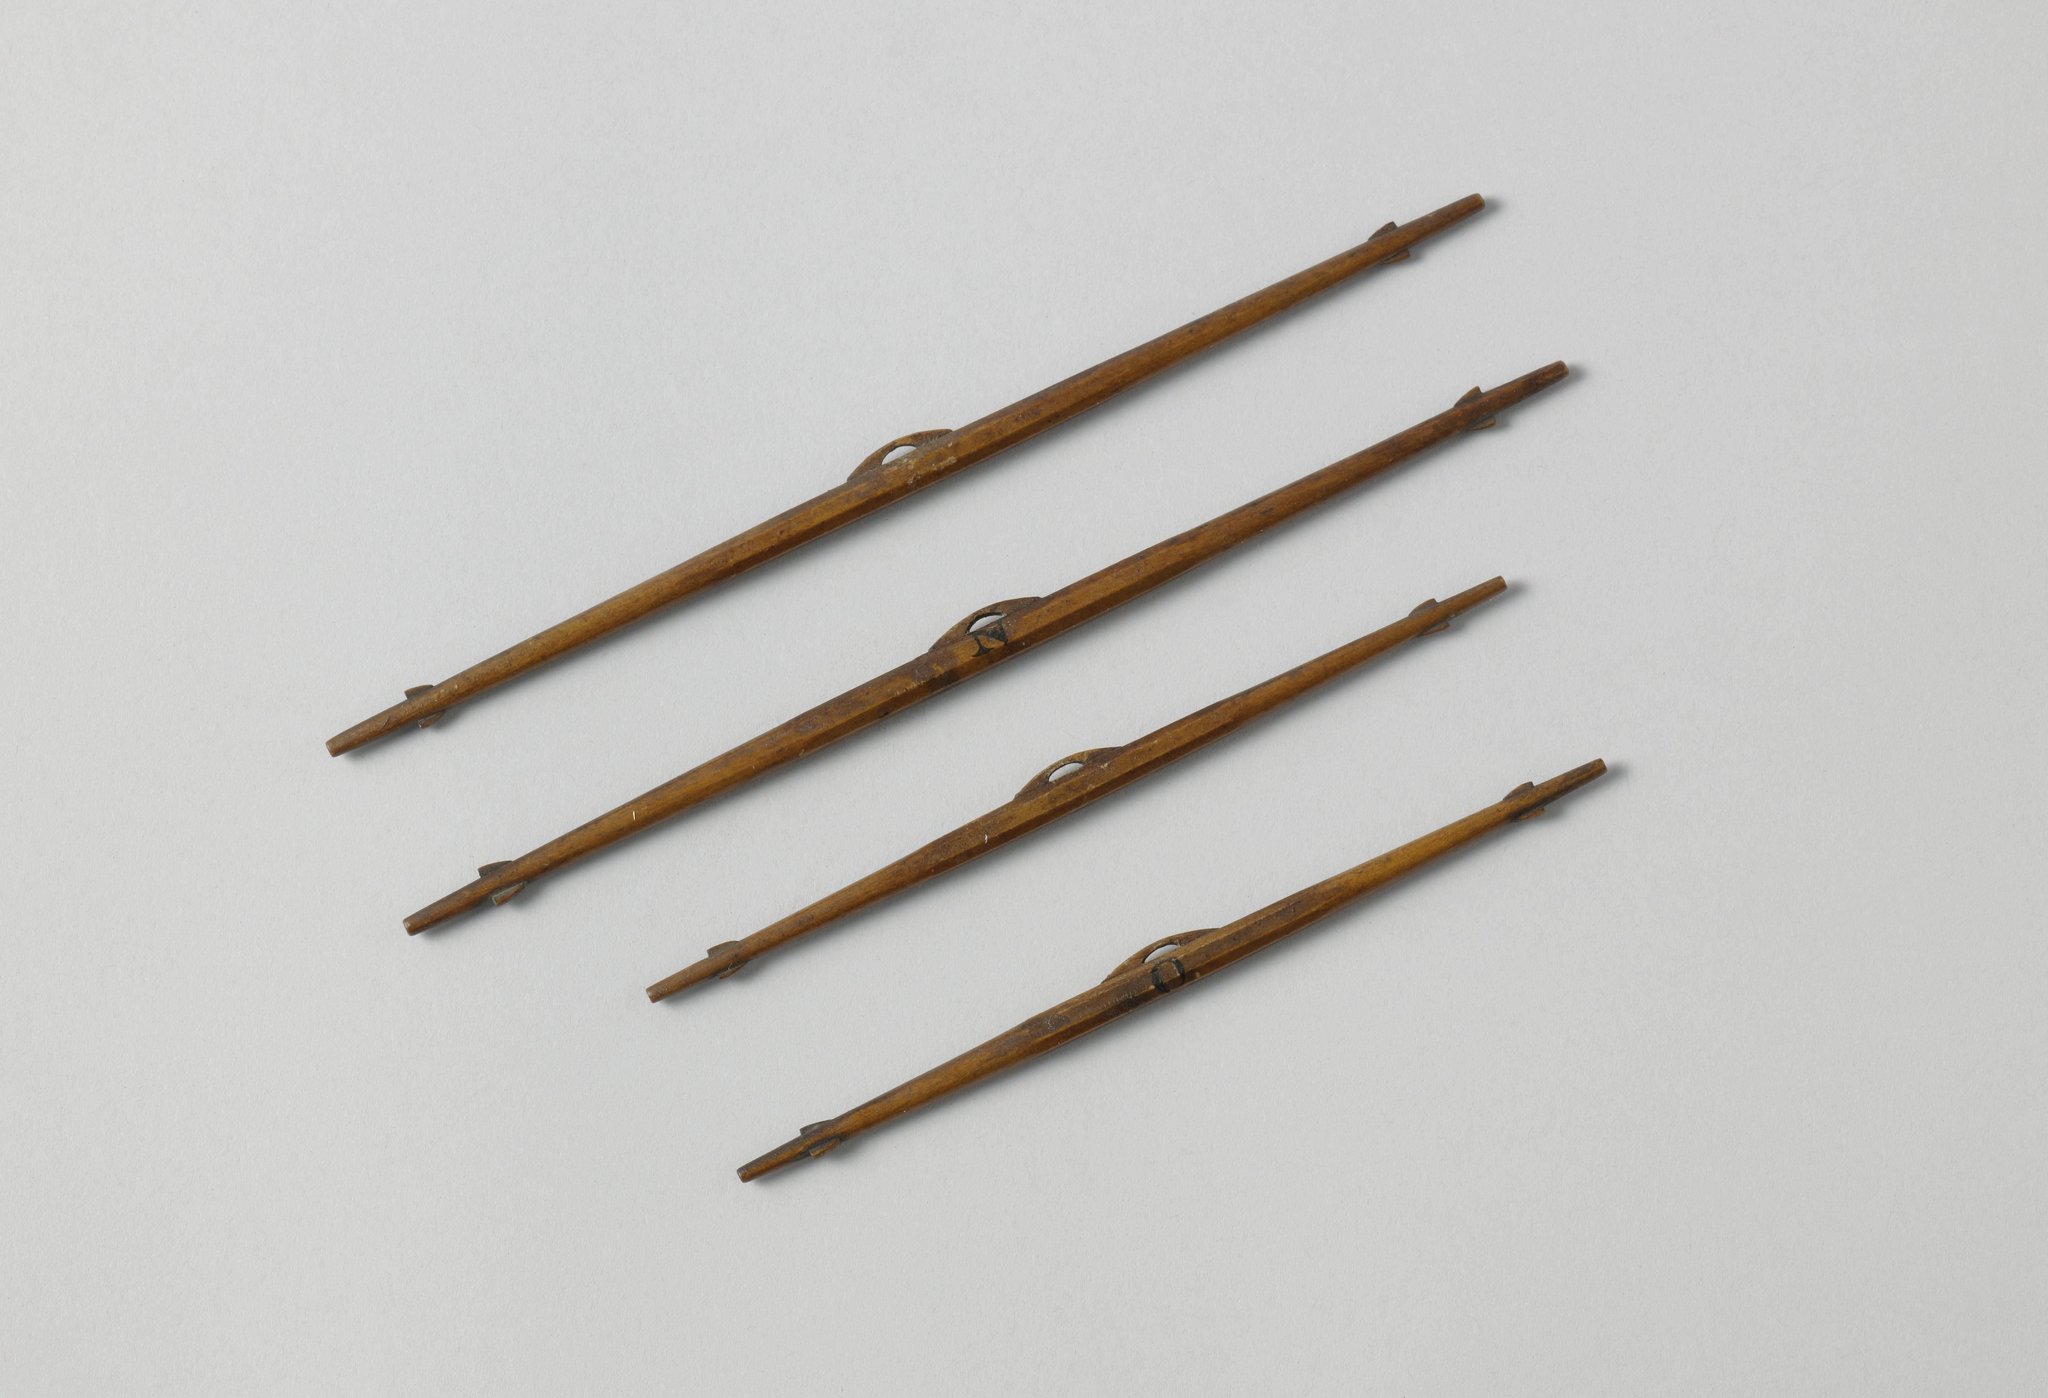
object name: demonstration model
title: Four Models of Main Skysail Yards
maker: Anonymous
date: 1850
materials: wood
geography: netherlands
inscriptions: inscription, on the two longer yards: ‘O’, inscription, on the two smaller yards: ‘N’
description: Deze modellen stellen de scheizeilra's van de Piet Hein voor, in 1833 als linieschip op stapel gezet, uiteengenomen en in 1853-1856 als eerste Nederlands schroefstoomfregat afgebouwd door A.E. Tromp in Amsterdam, lang 59.62 m, herdoopt de Admiraal van Wassenaer. Samen met een aantal andere modellen van rondhouten kan de gehele grote mast gevormd worden.